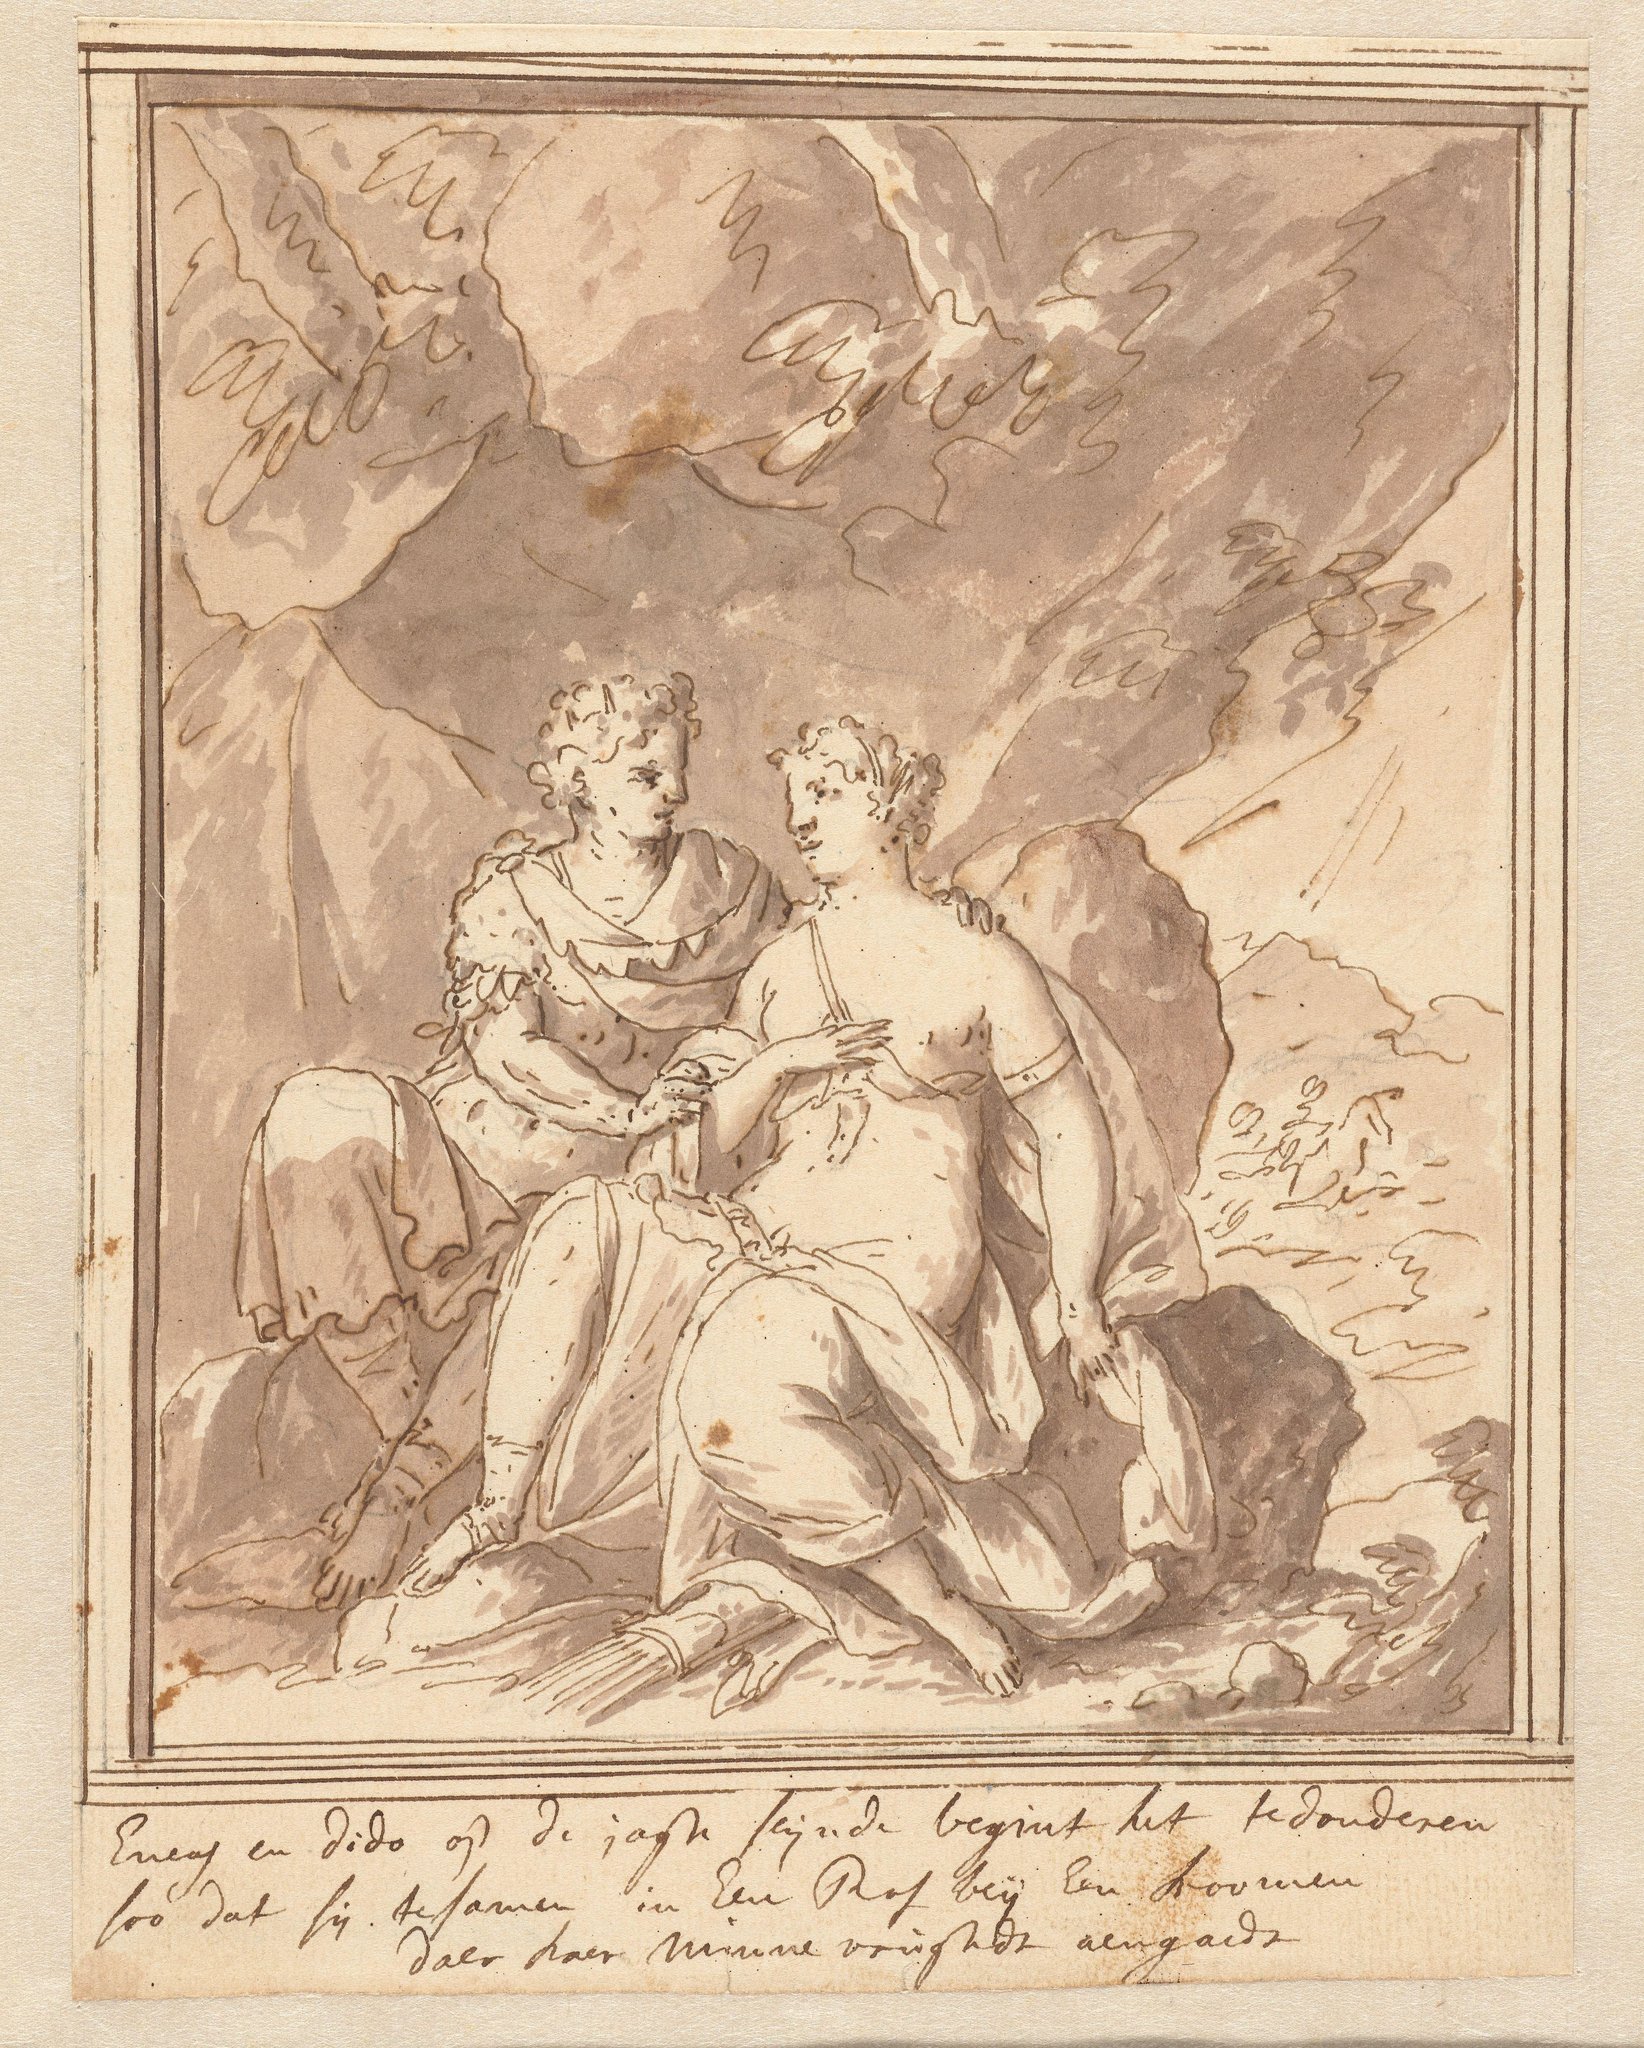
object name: drawing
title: Ontwerpen voor schilderijen met episodes uit De Aeneas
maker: mattheus terwesten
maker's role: draughtsman, painter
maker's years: 1670-1757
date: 1700-1704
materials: ink, paper, pencil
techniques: brush, pen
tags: dido and aeneas shelter from the storm in a cave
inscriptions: : ‘Eneas en dido op de jagt seynde begint het te donderen soo dat sij te samen in Een Ros bij een koomen daer haer minne vreughdt aengaedt.’